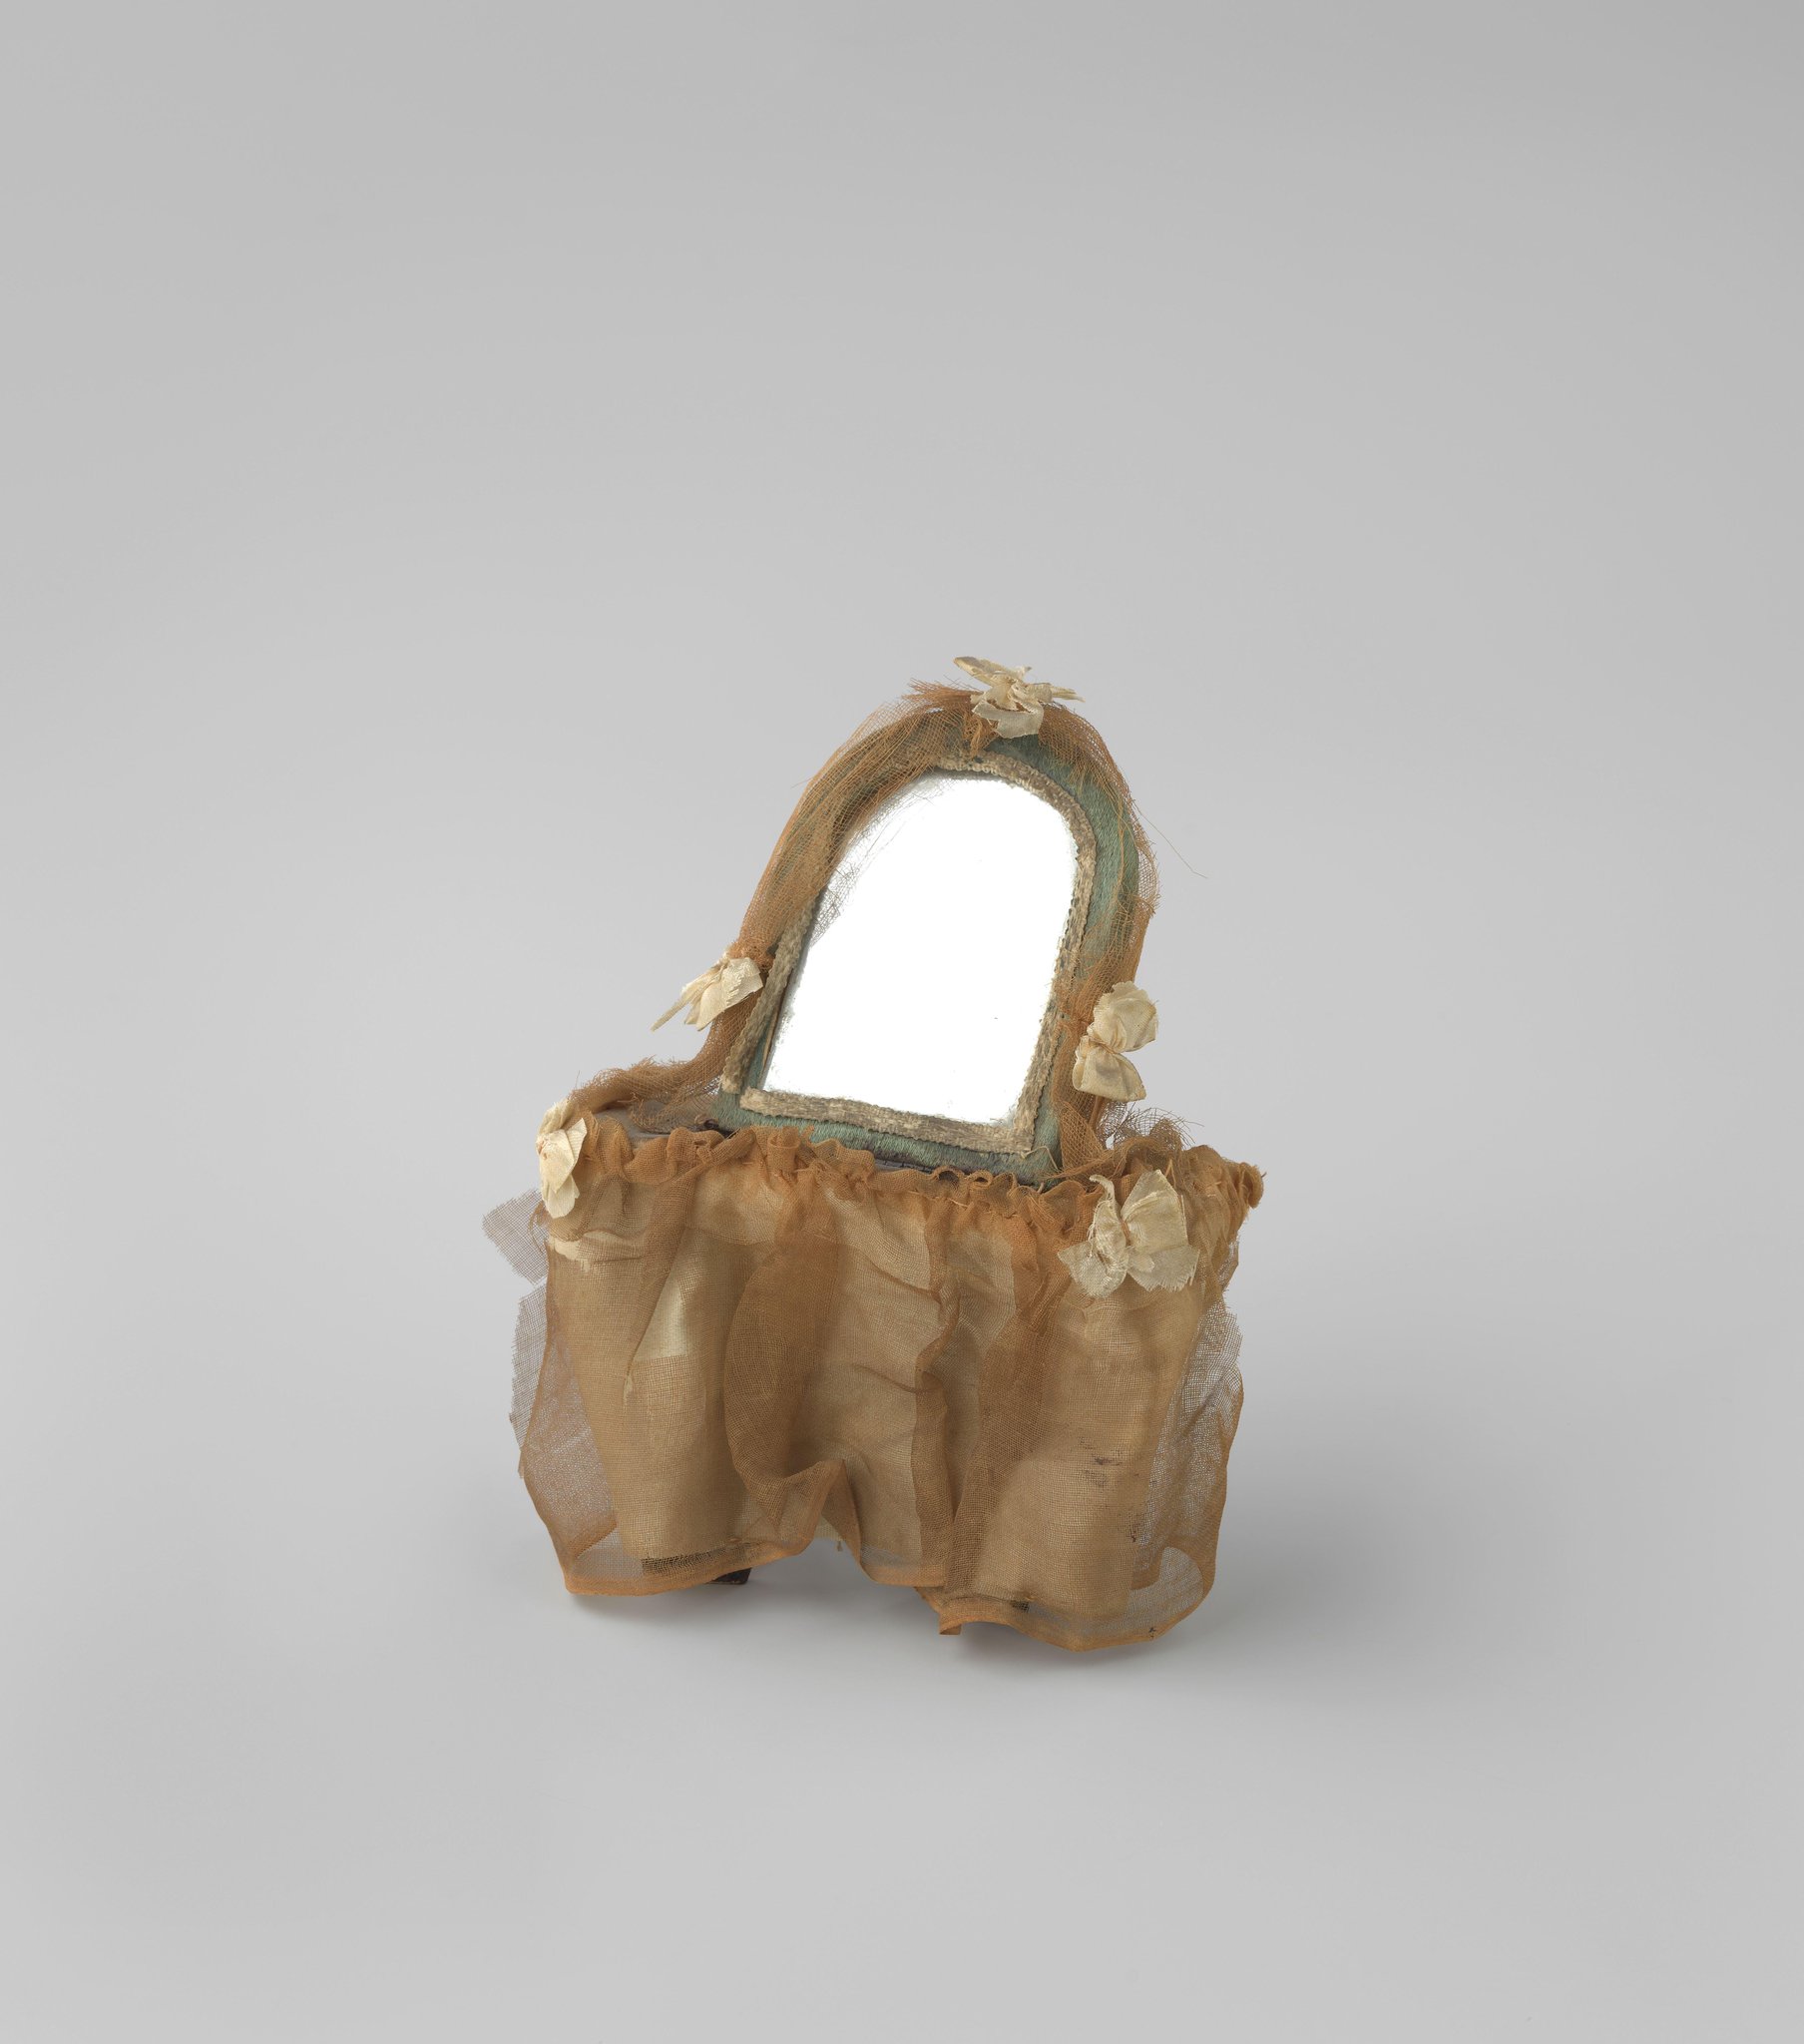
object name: kaptafel, toilettafel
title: Toilettafel, bekleed met witte en blauwe zijde en gaas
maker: Anonymous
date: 1750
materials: cardboard, glass, silk, wood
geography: amsterdam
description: De toilettafel bestaat uit een tafelblad op een vast, zwartgelakt onderstel, waarop een spiegel staat, ondersteund met een houten lat. Het tafelblad en de spiegel zijn bekleed met blauwe zijde, afgezet met wit band. Rondom de tafel hangt een aangerimpeld kleed van zijde en gaas, om de spiegel is een doek van gaas gedrapeerd; vijf strikken van zijde sieren de hoeken van het blad en de spiegel.